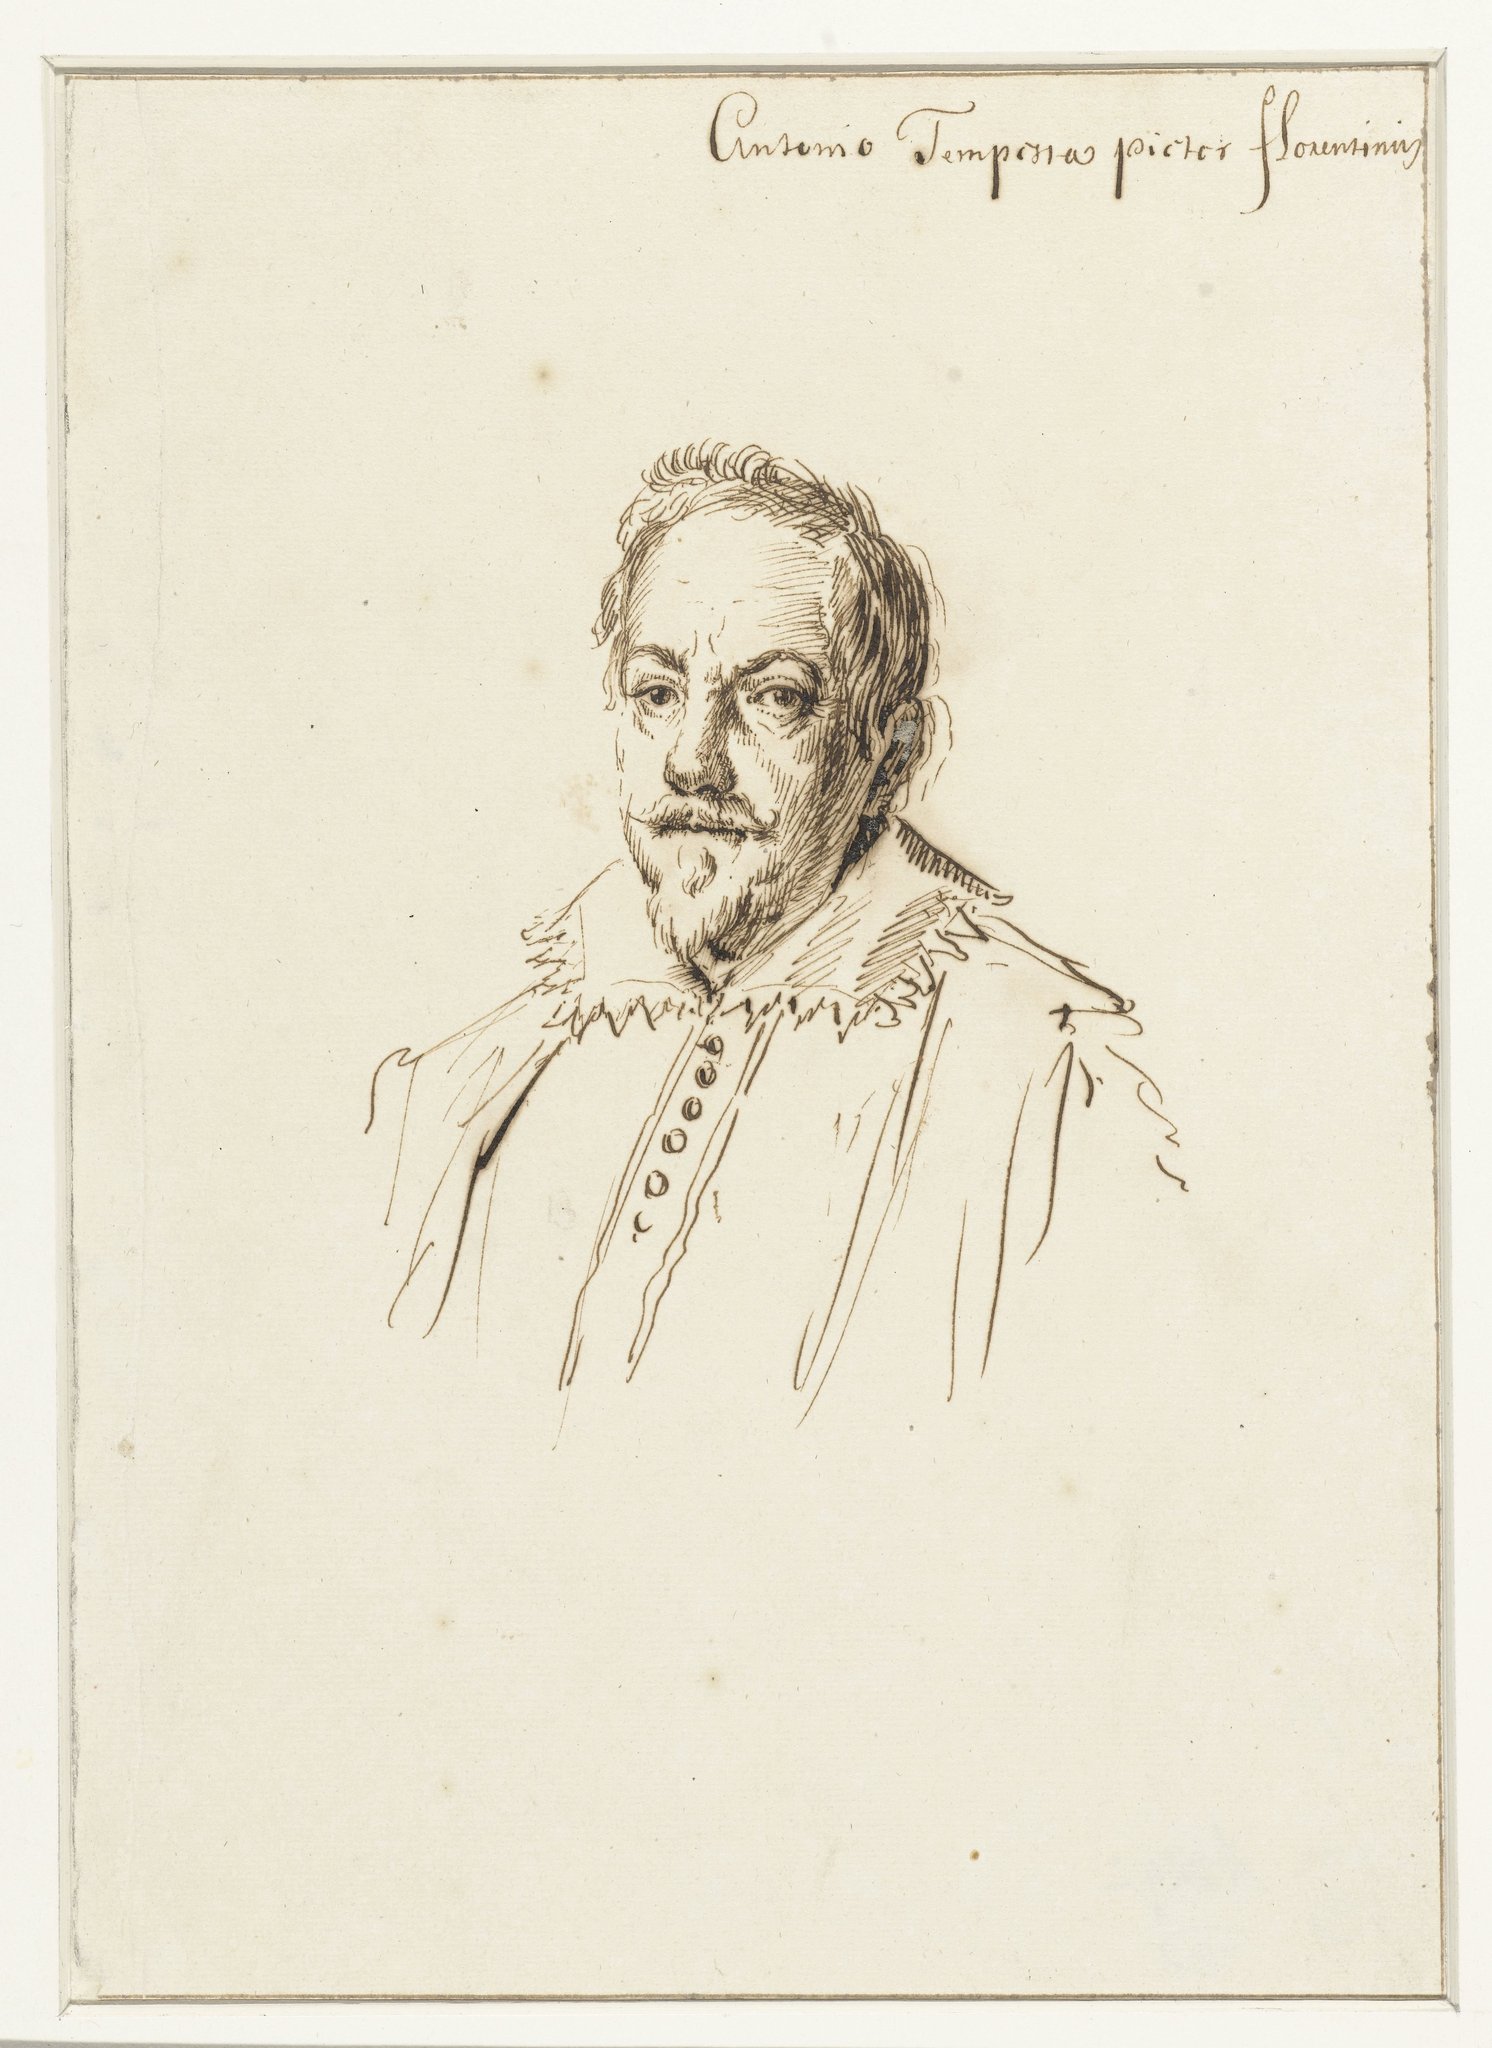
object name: drawing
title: Portret van Antonio Tempesta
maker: Anonymous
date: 1623-1673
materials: ink, paper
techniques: pen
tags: rome, painter, print maker, draughtsman, antonio tempesta, historical persons, portrait, self-portrait of painter, portrait, self-portrait of artist, portrait, self-portrait of graphic artist